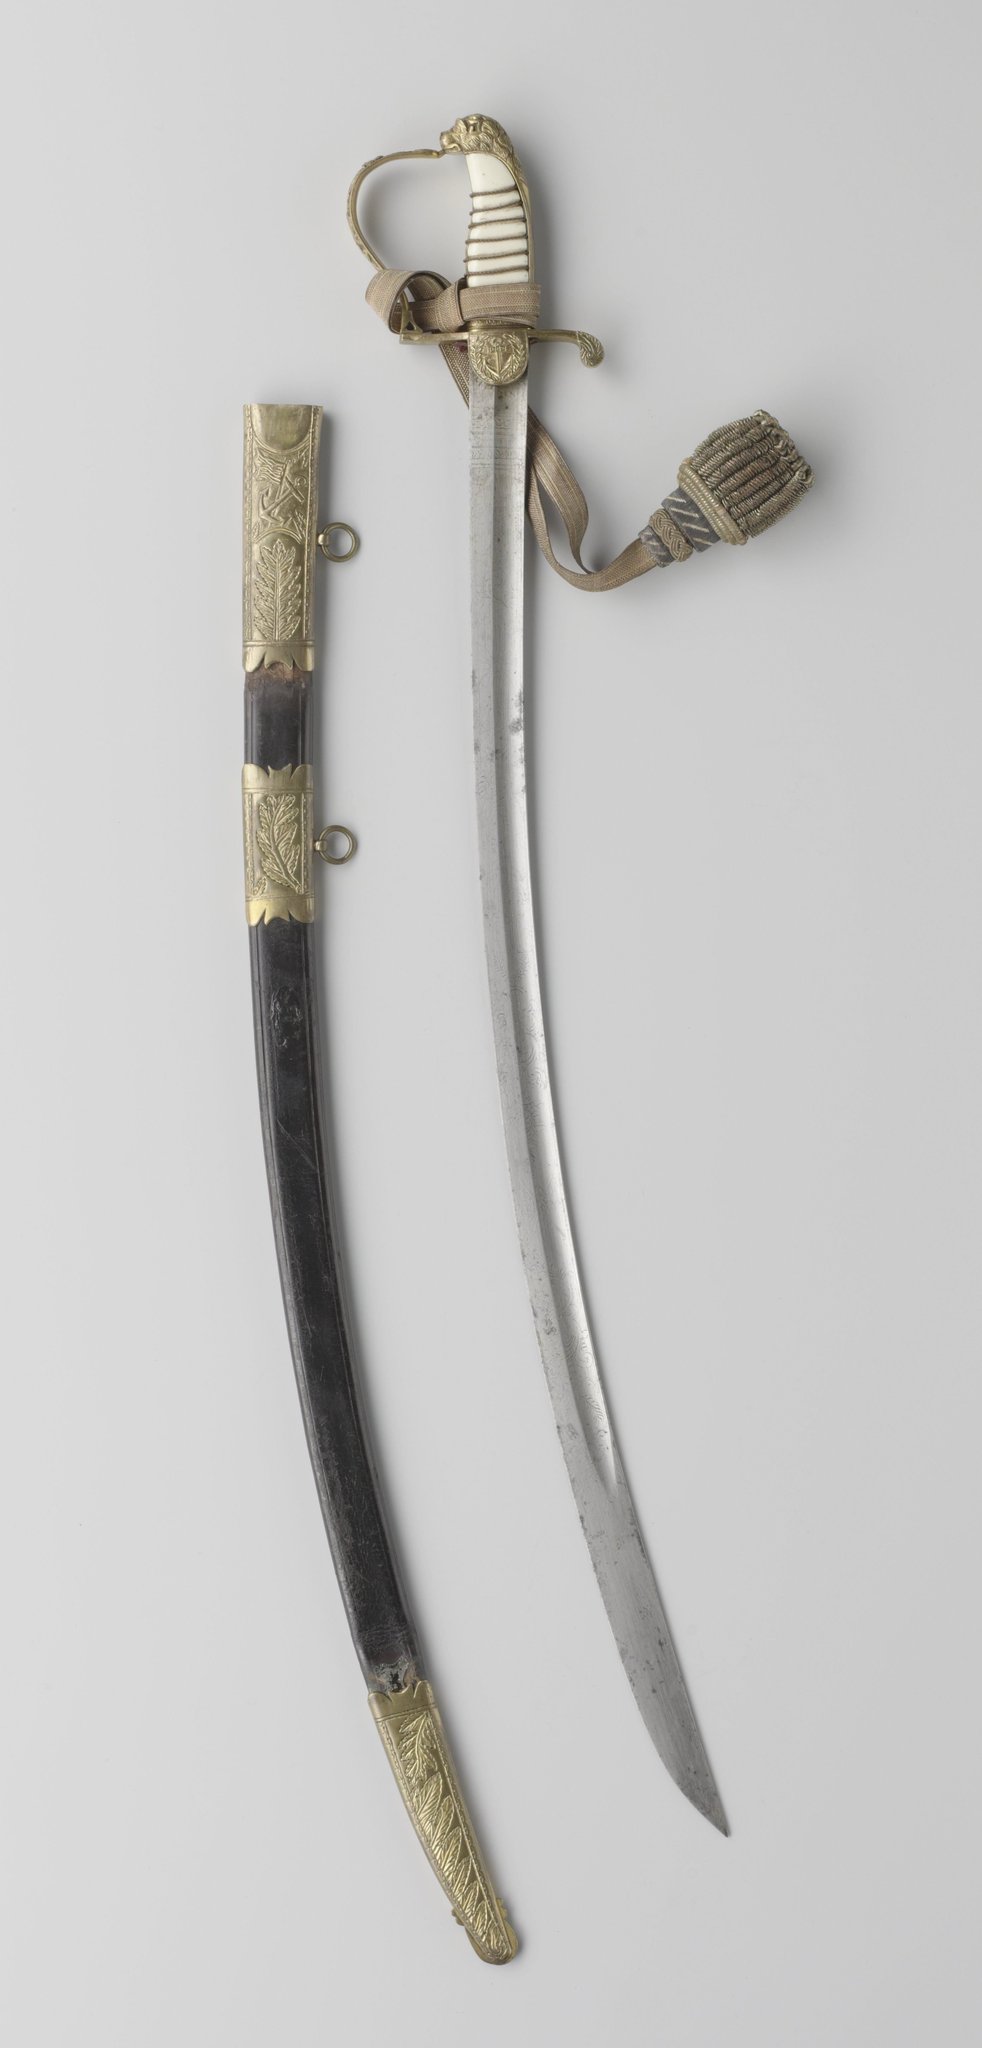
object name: sabre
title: Officierssabel met schede voor marine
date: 1800-1825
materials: copper, iron, ivory, leather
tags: utrecht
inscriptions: : ‘P. knecht Solingen’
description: Marinesabel van officier. De kling heeft een brede geul en is versierd met ornamenten ankers en marine-emblemen, met opschrift: P. knecht Solingen. De greep is van gegoten koper en been met koperdraad omwoeld. Met trofee versierde beugel. Schild stootplaten waarop anker en lauwerkrans. Knop in de vorm van een leeuwenkop. Met sabelkwast en zwart leren schede met versierd koperen montuur met afbeelding van anker en ringen. Afkomstig van J.C. Koopman.